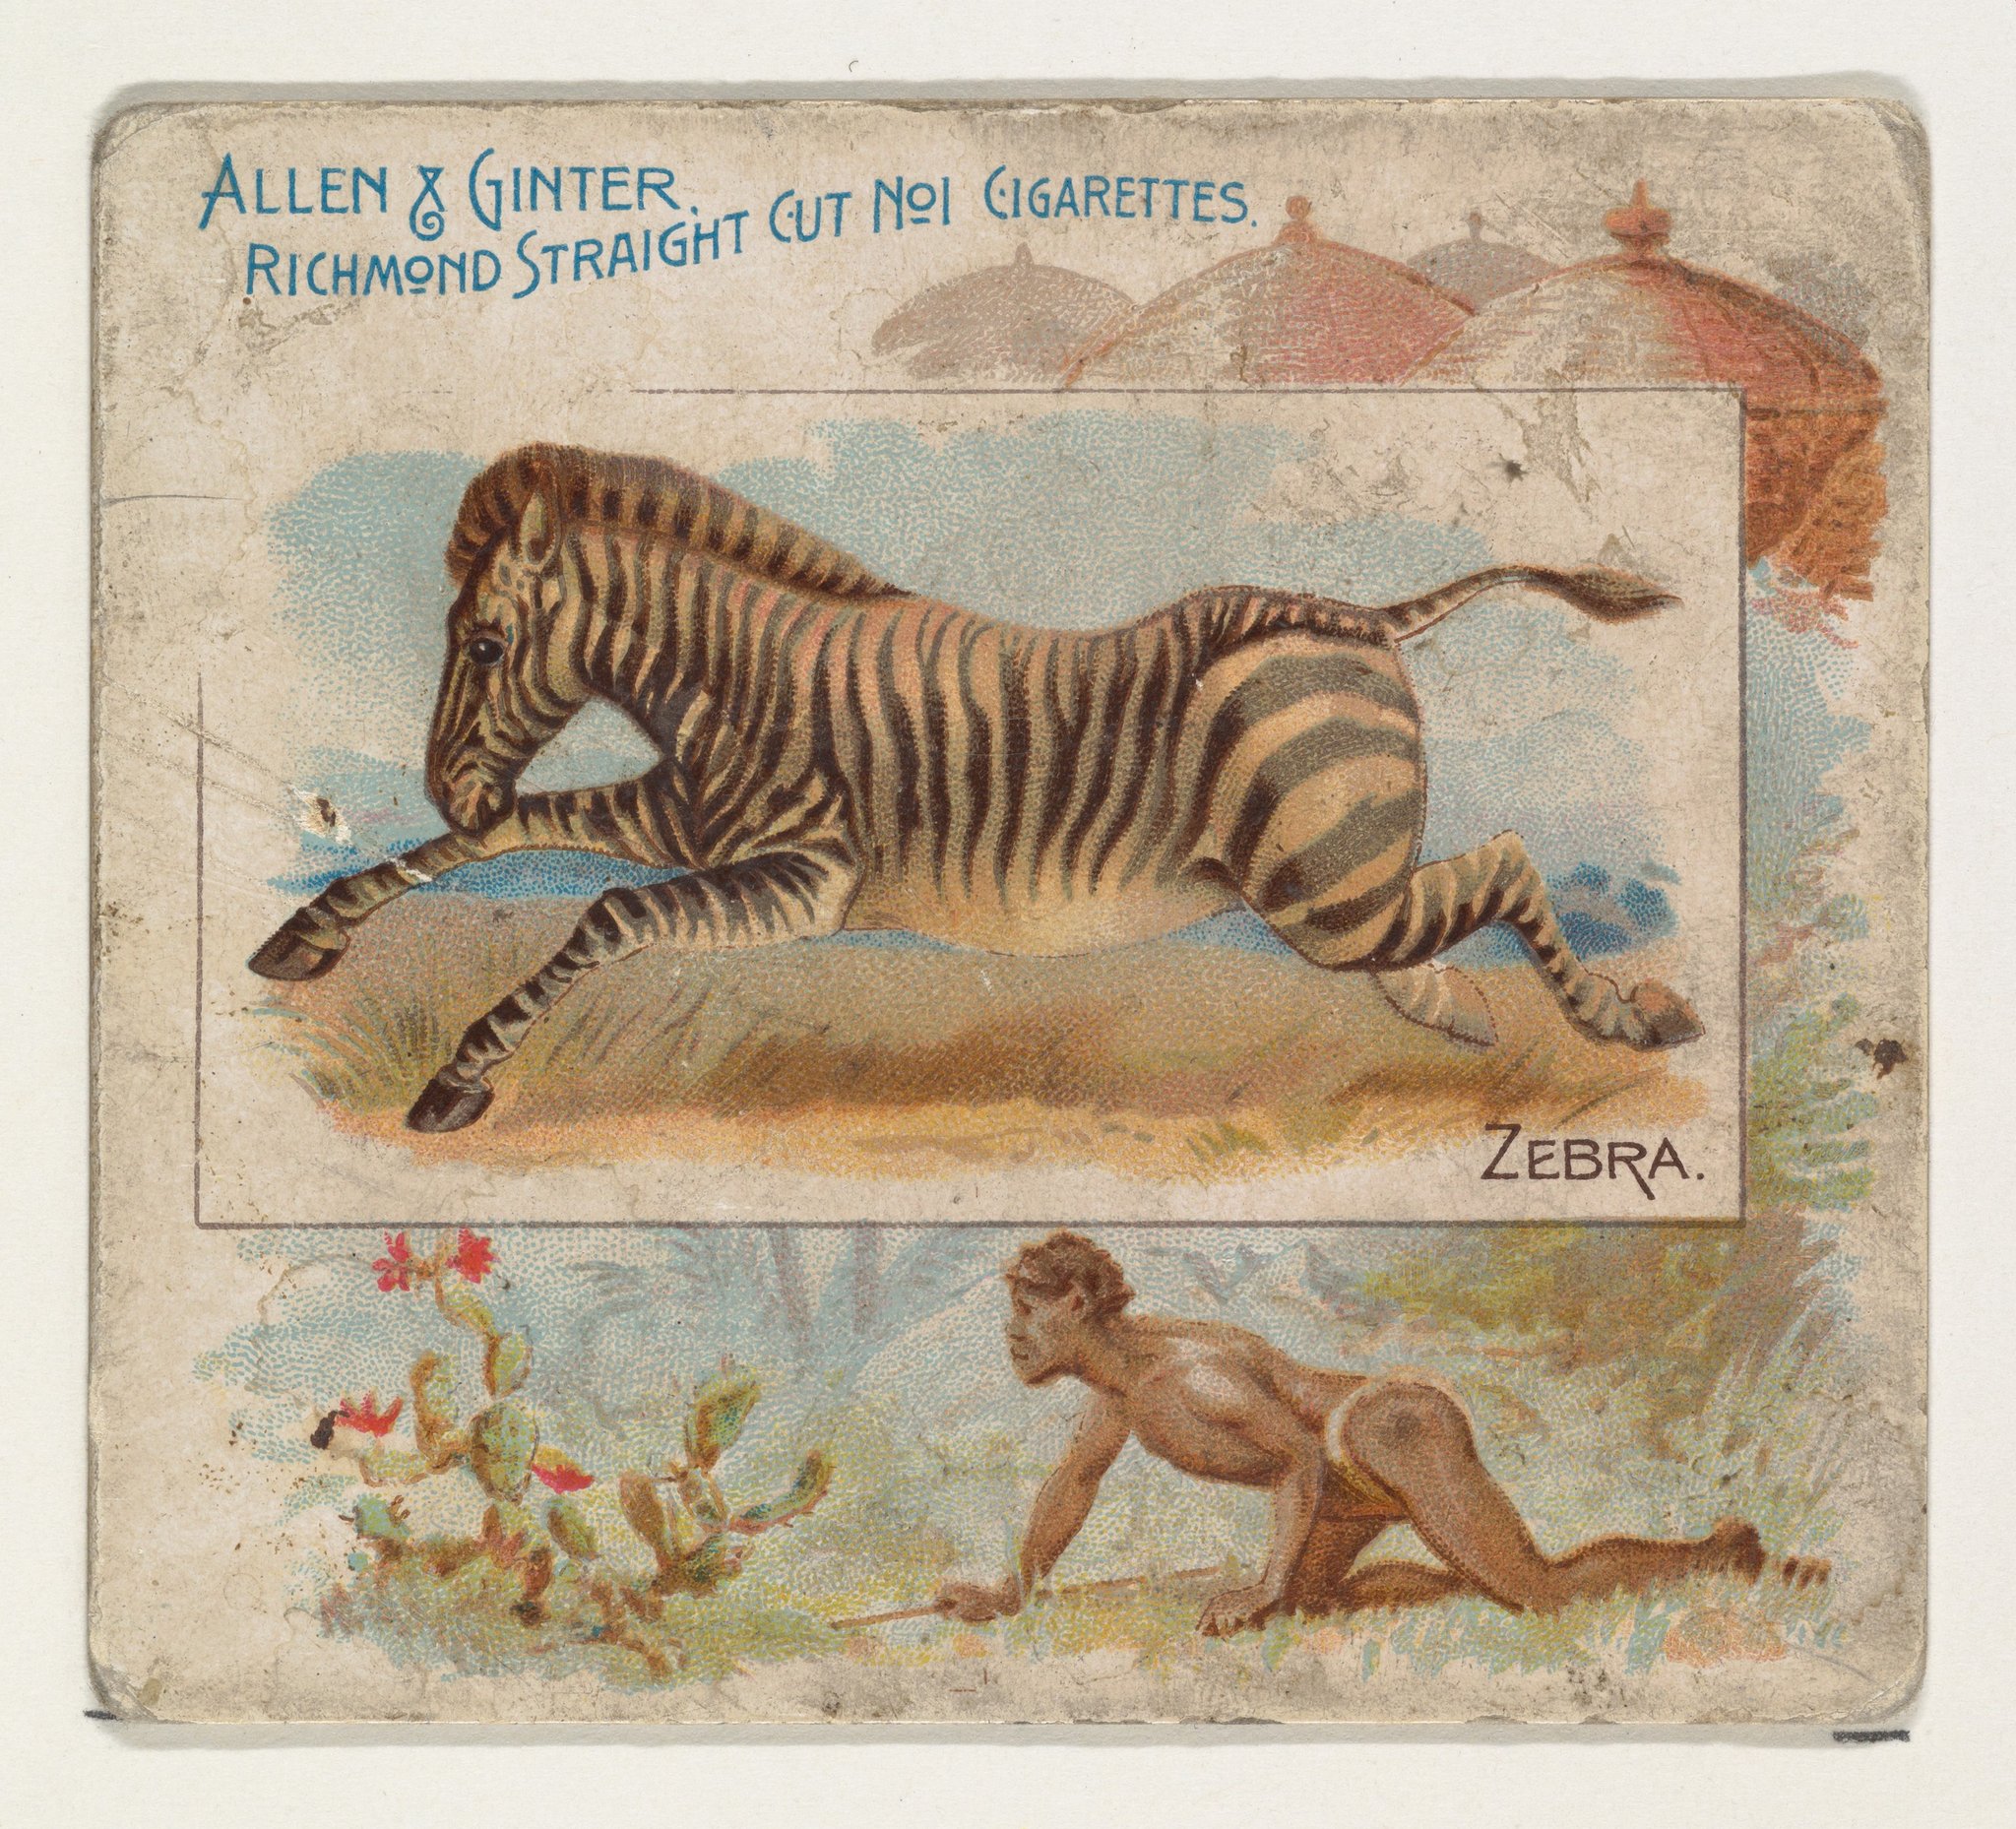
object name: print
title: Zebra, from Quadrupeds series (N41) for Allen & Ginter Cigarettes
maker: allen & ginter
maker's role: publisher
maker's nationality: american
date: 1890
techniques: color lithograph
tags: zebras